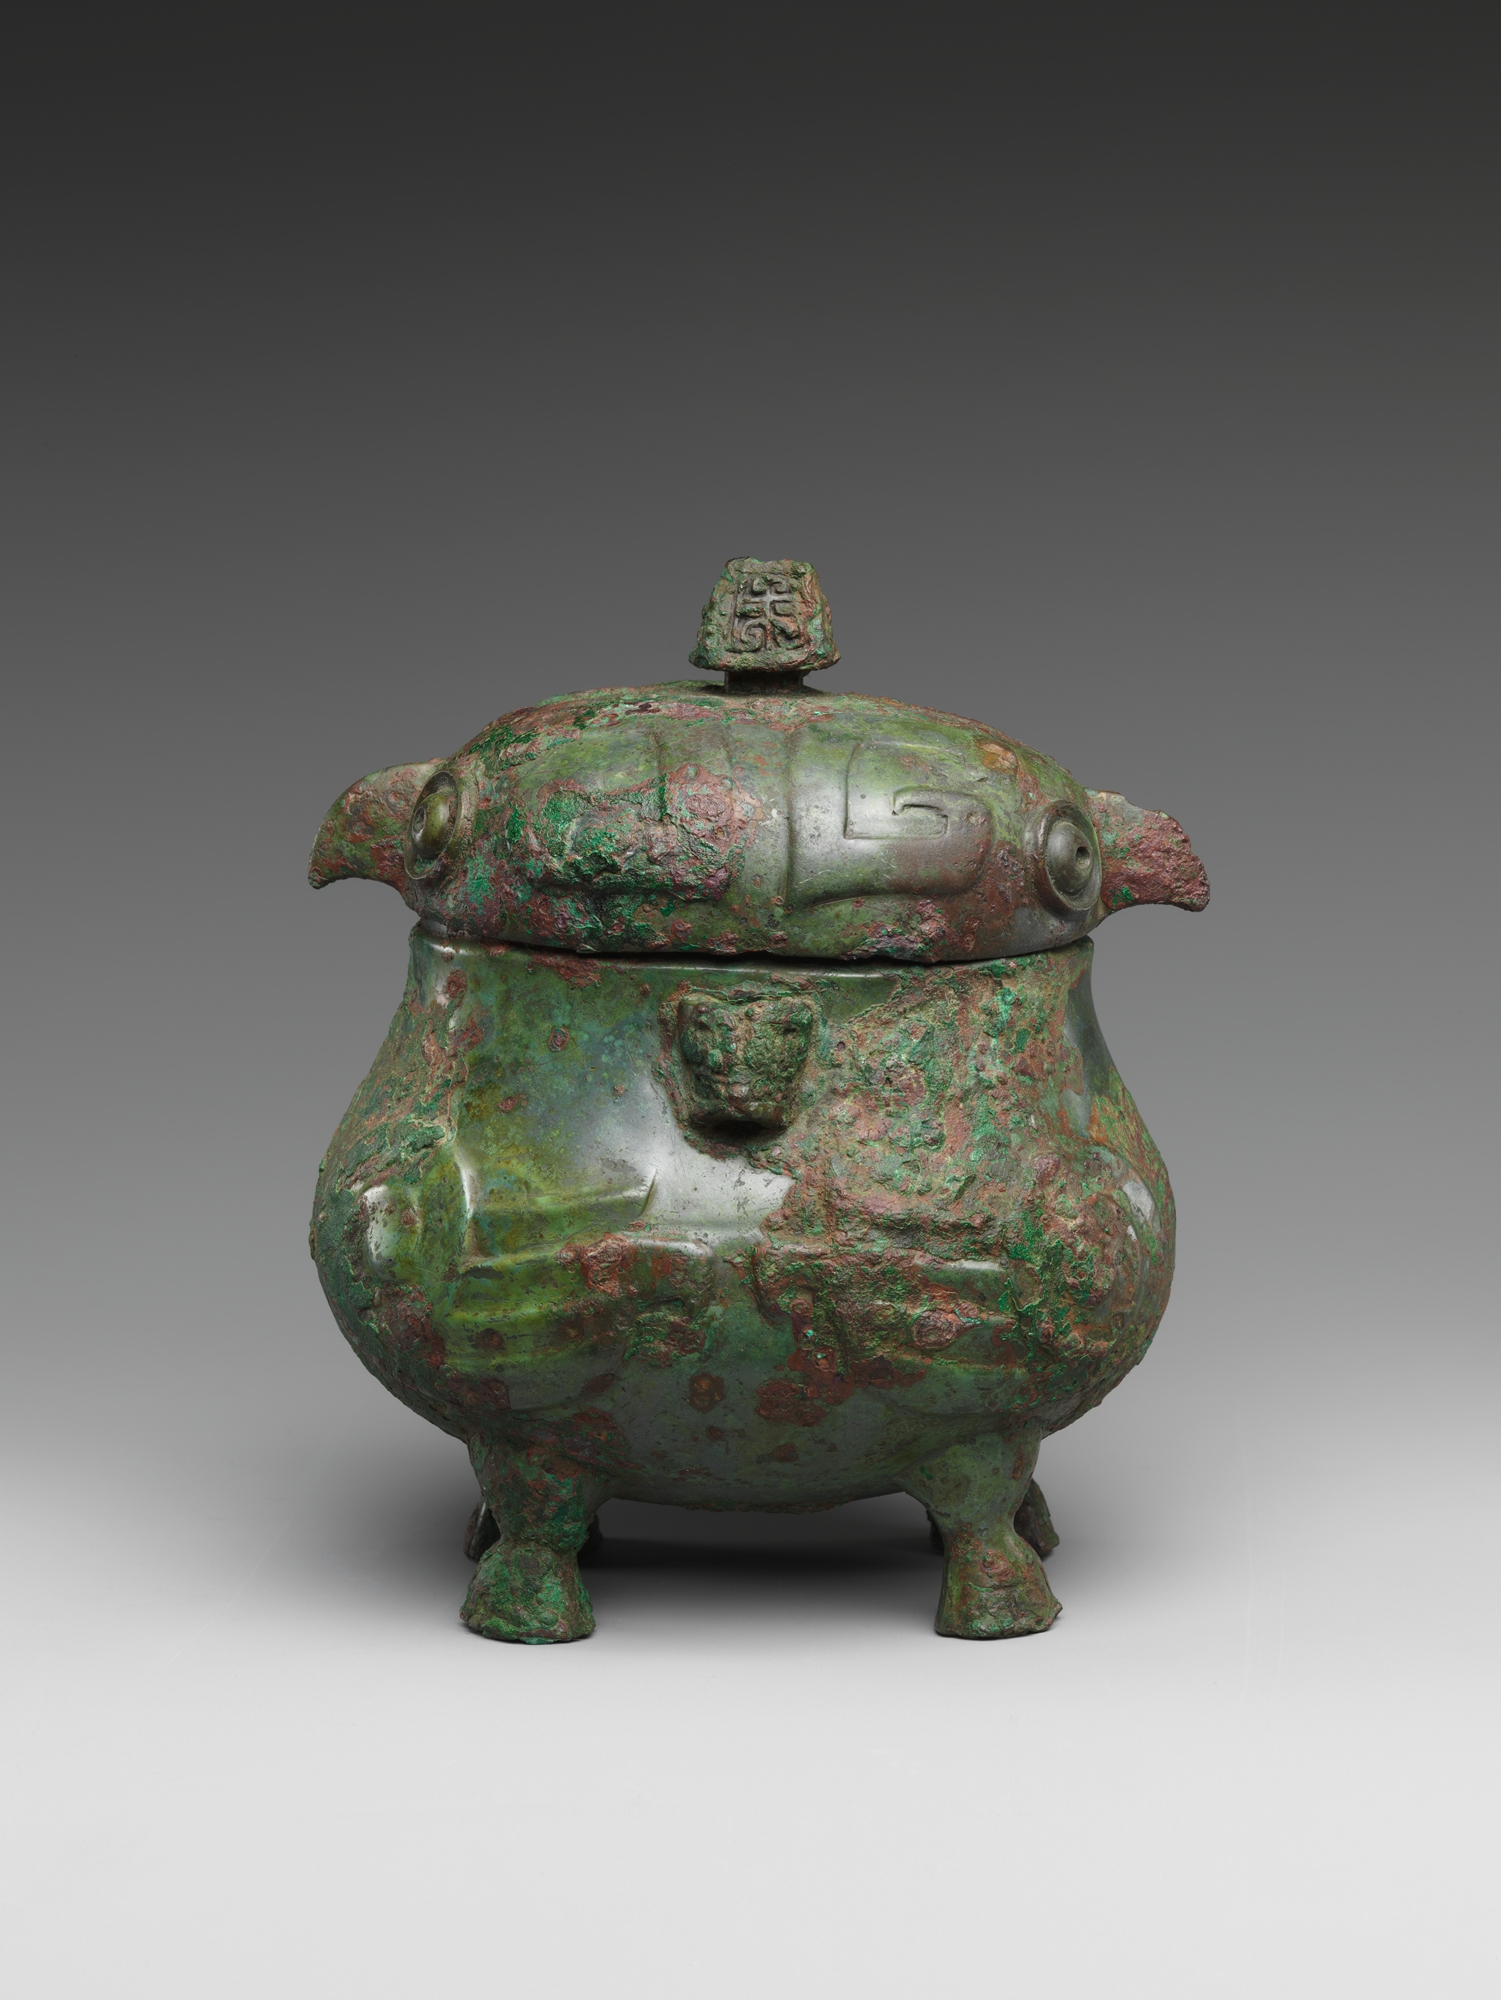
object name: wine cup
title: Wine cup in the shape of addorsed owls (Zhi)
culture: chinese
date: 1200-1101 BCE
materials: bronze